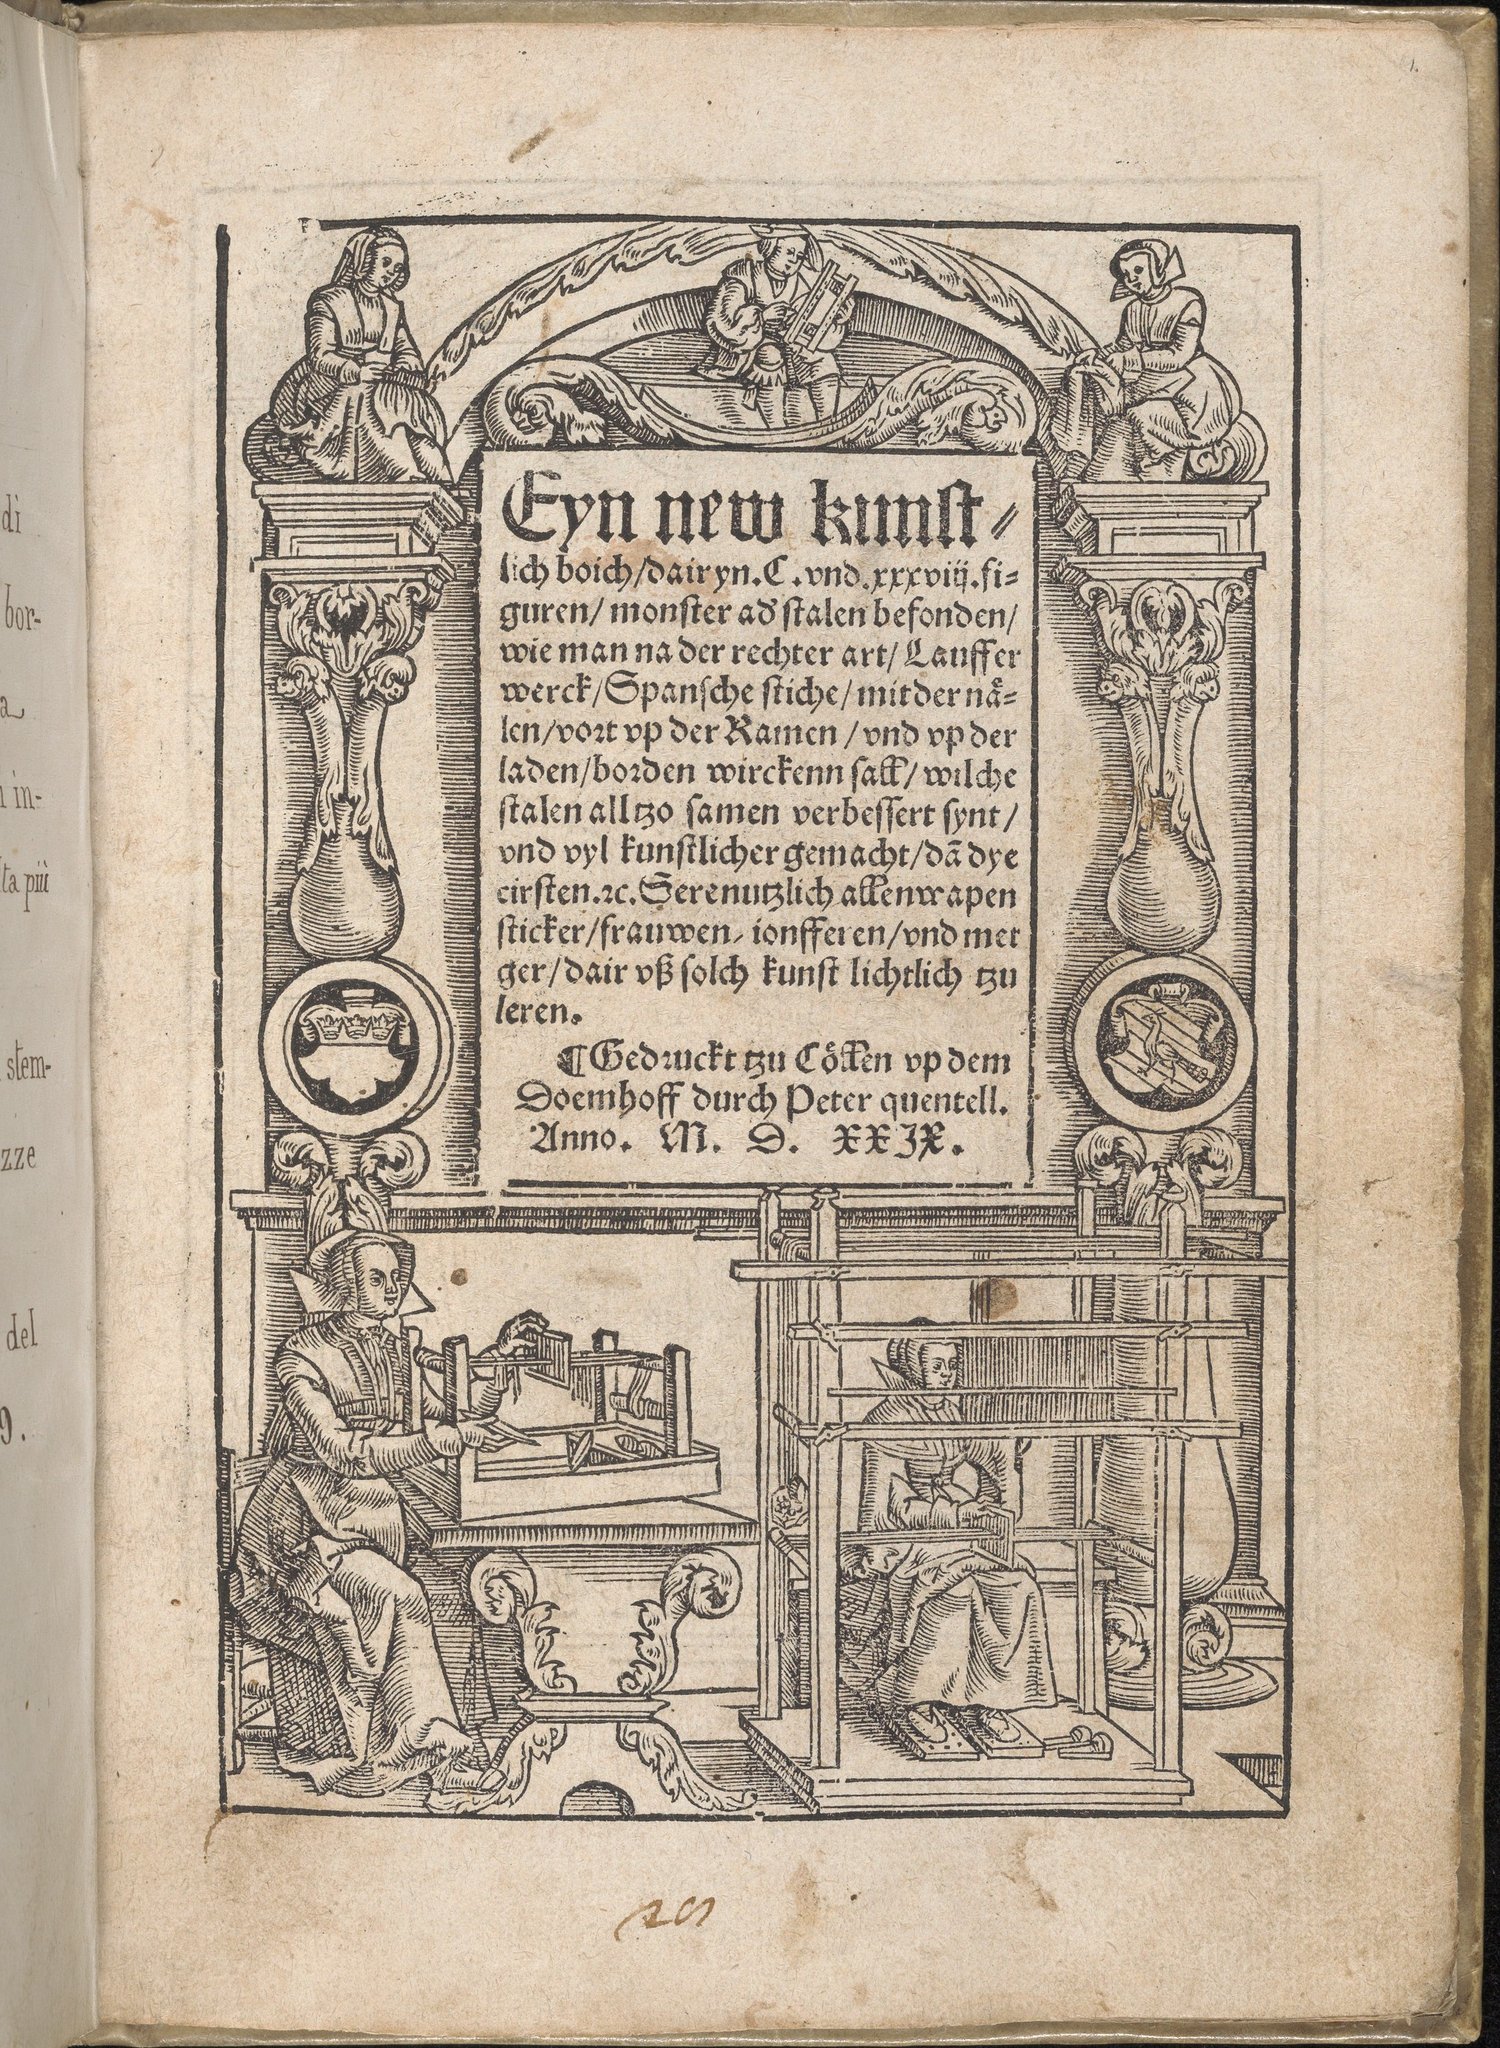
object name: book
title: Title page (2 recto), from "Eyn New Kunstlichboich"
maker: peter quentel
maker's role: publisher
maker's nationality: german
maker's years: 1500-1550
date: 1529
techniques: woodcut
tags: men,women,writing